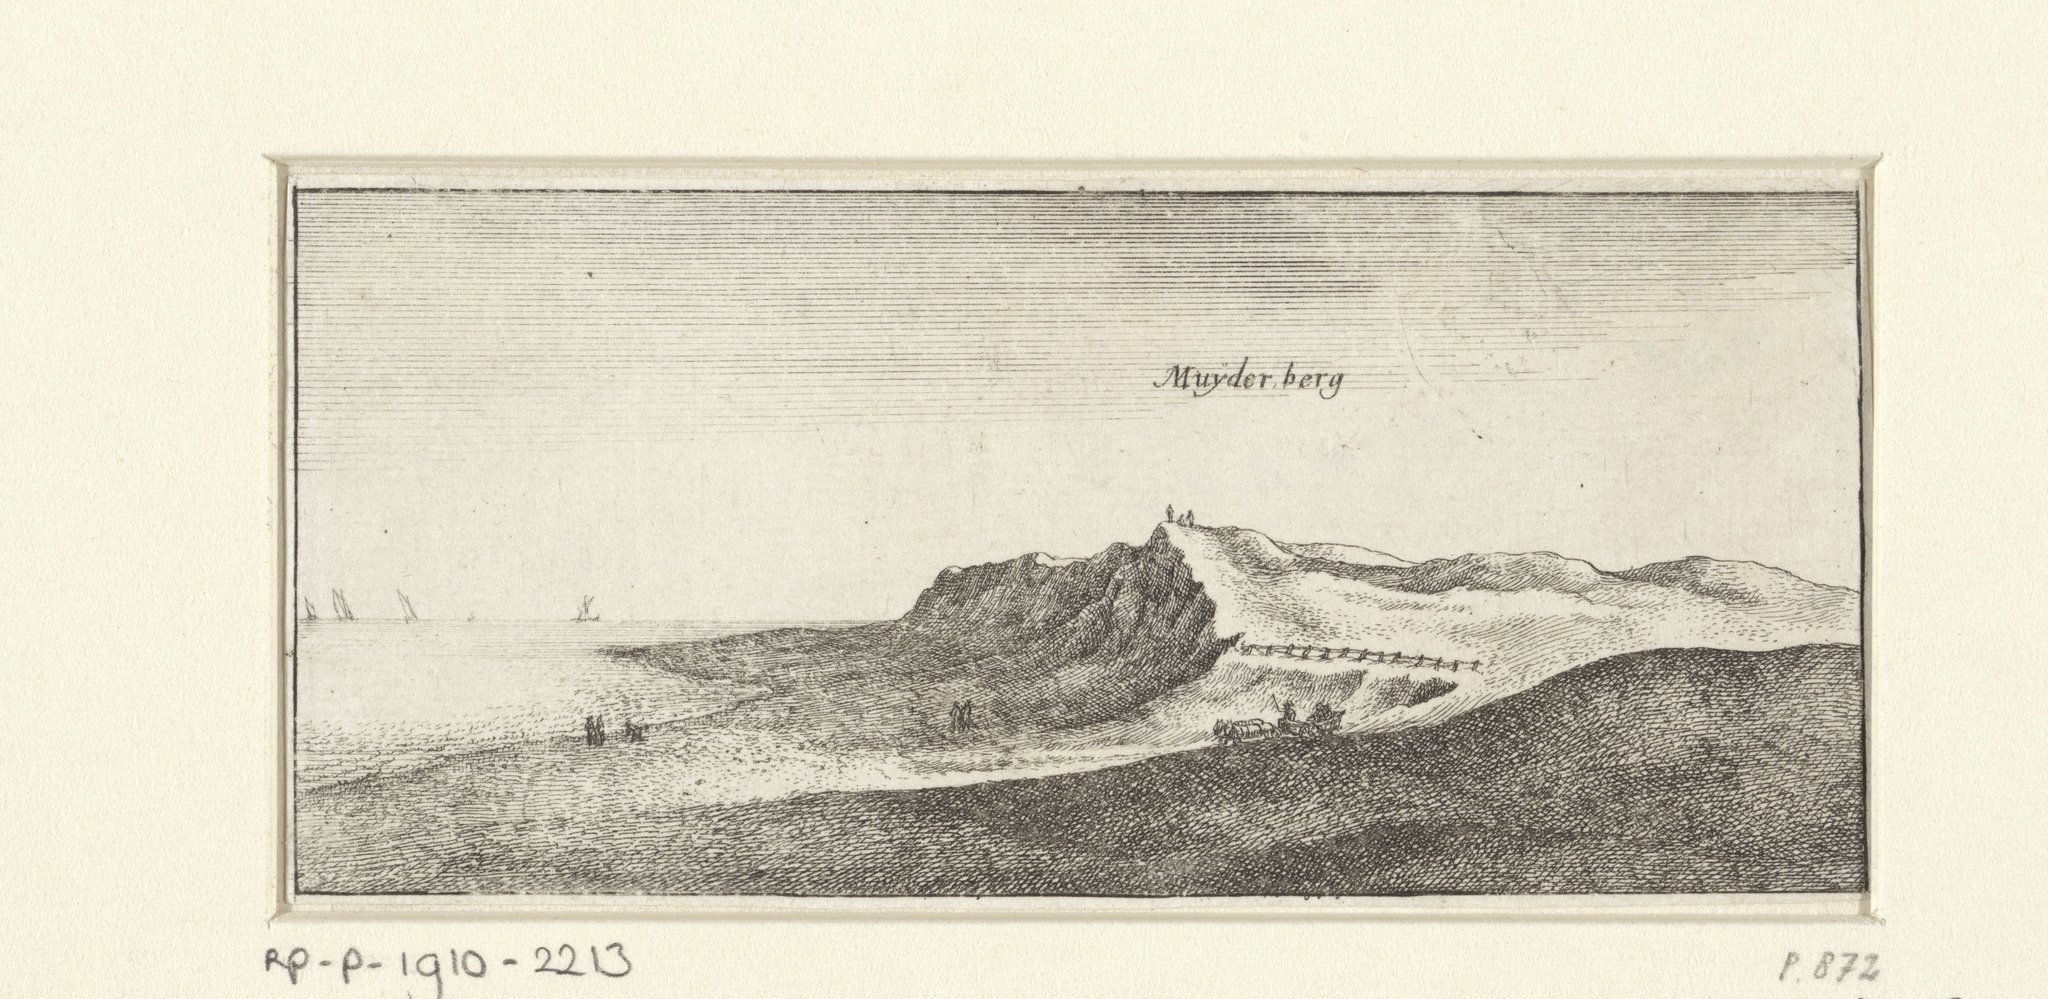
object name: print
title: Landschap met gezicht op Muiderberg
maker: wenceslaus hollar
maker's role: draughtsman, print maker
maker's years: 1607-1677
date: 1625-1677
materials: paper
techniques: etching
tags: river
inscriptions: collector's mark: Lugt 2228